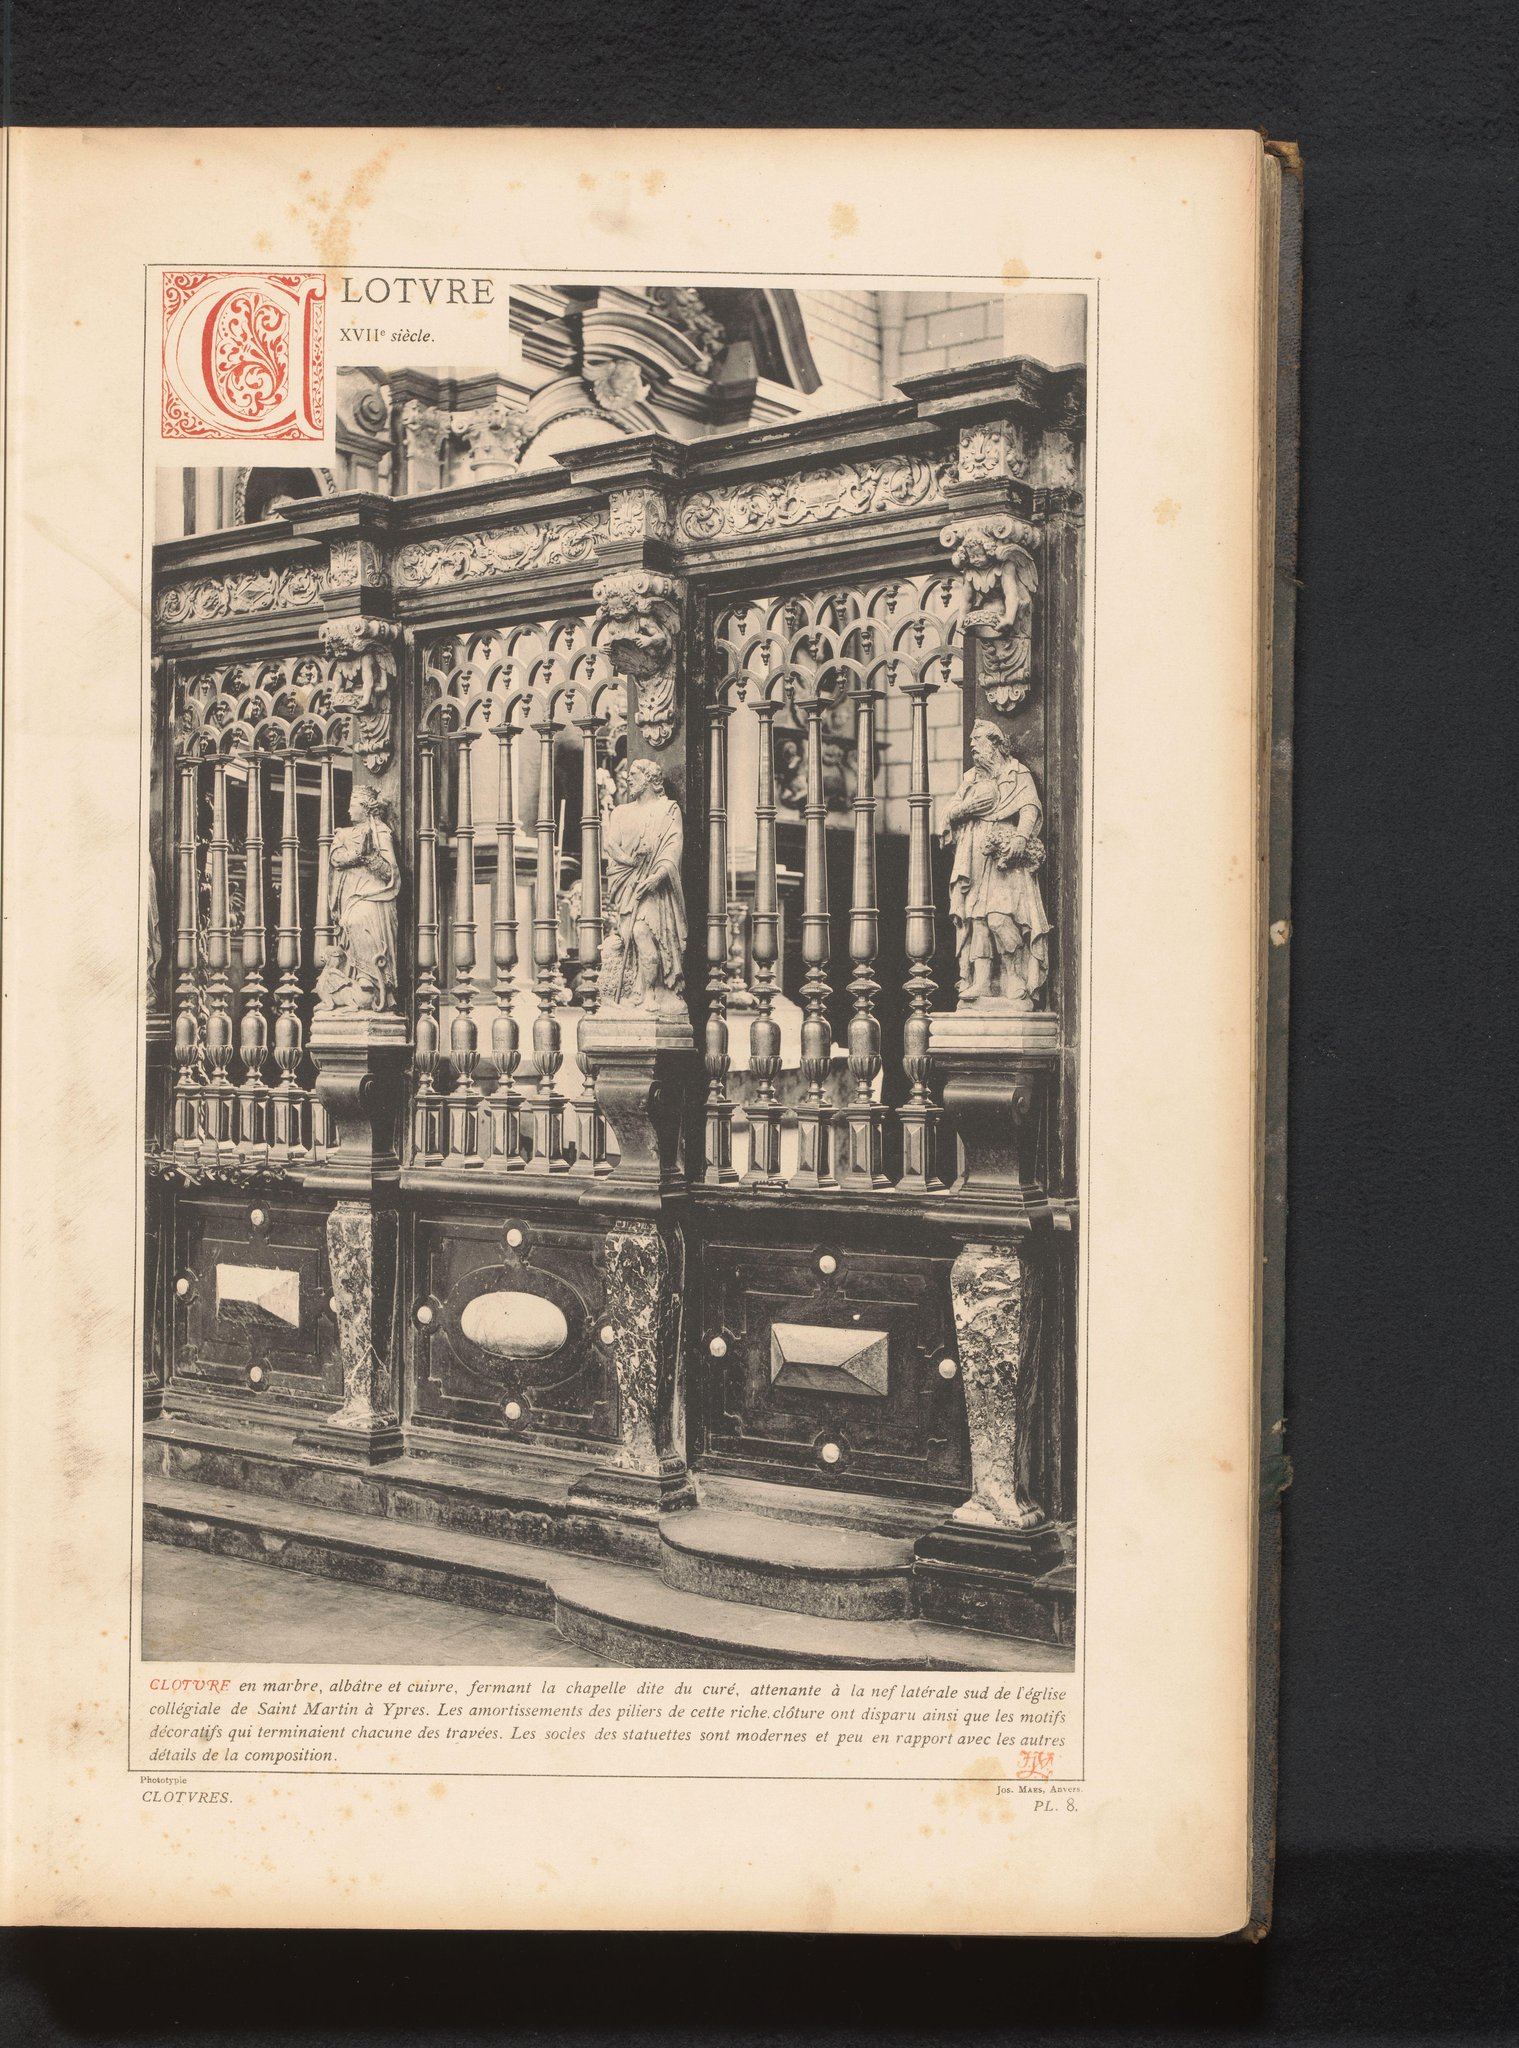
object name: photomechanical print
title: Koorhek van marmer in de Sint-Maartenskerk in Ieper, België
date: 1882-1887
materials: paper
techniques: photograph, photolithography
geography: ieper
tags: parts of church interior: choir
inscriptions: monogram: ‘JJvY’, inscription: ‘CLOTURE en marbre (...)’, inscription: ‘CLOTURES. - PL. 8.’